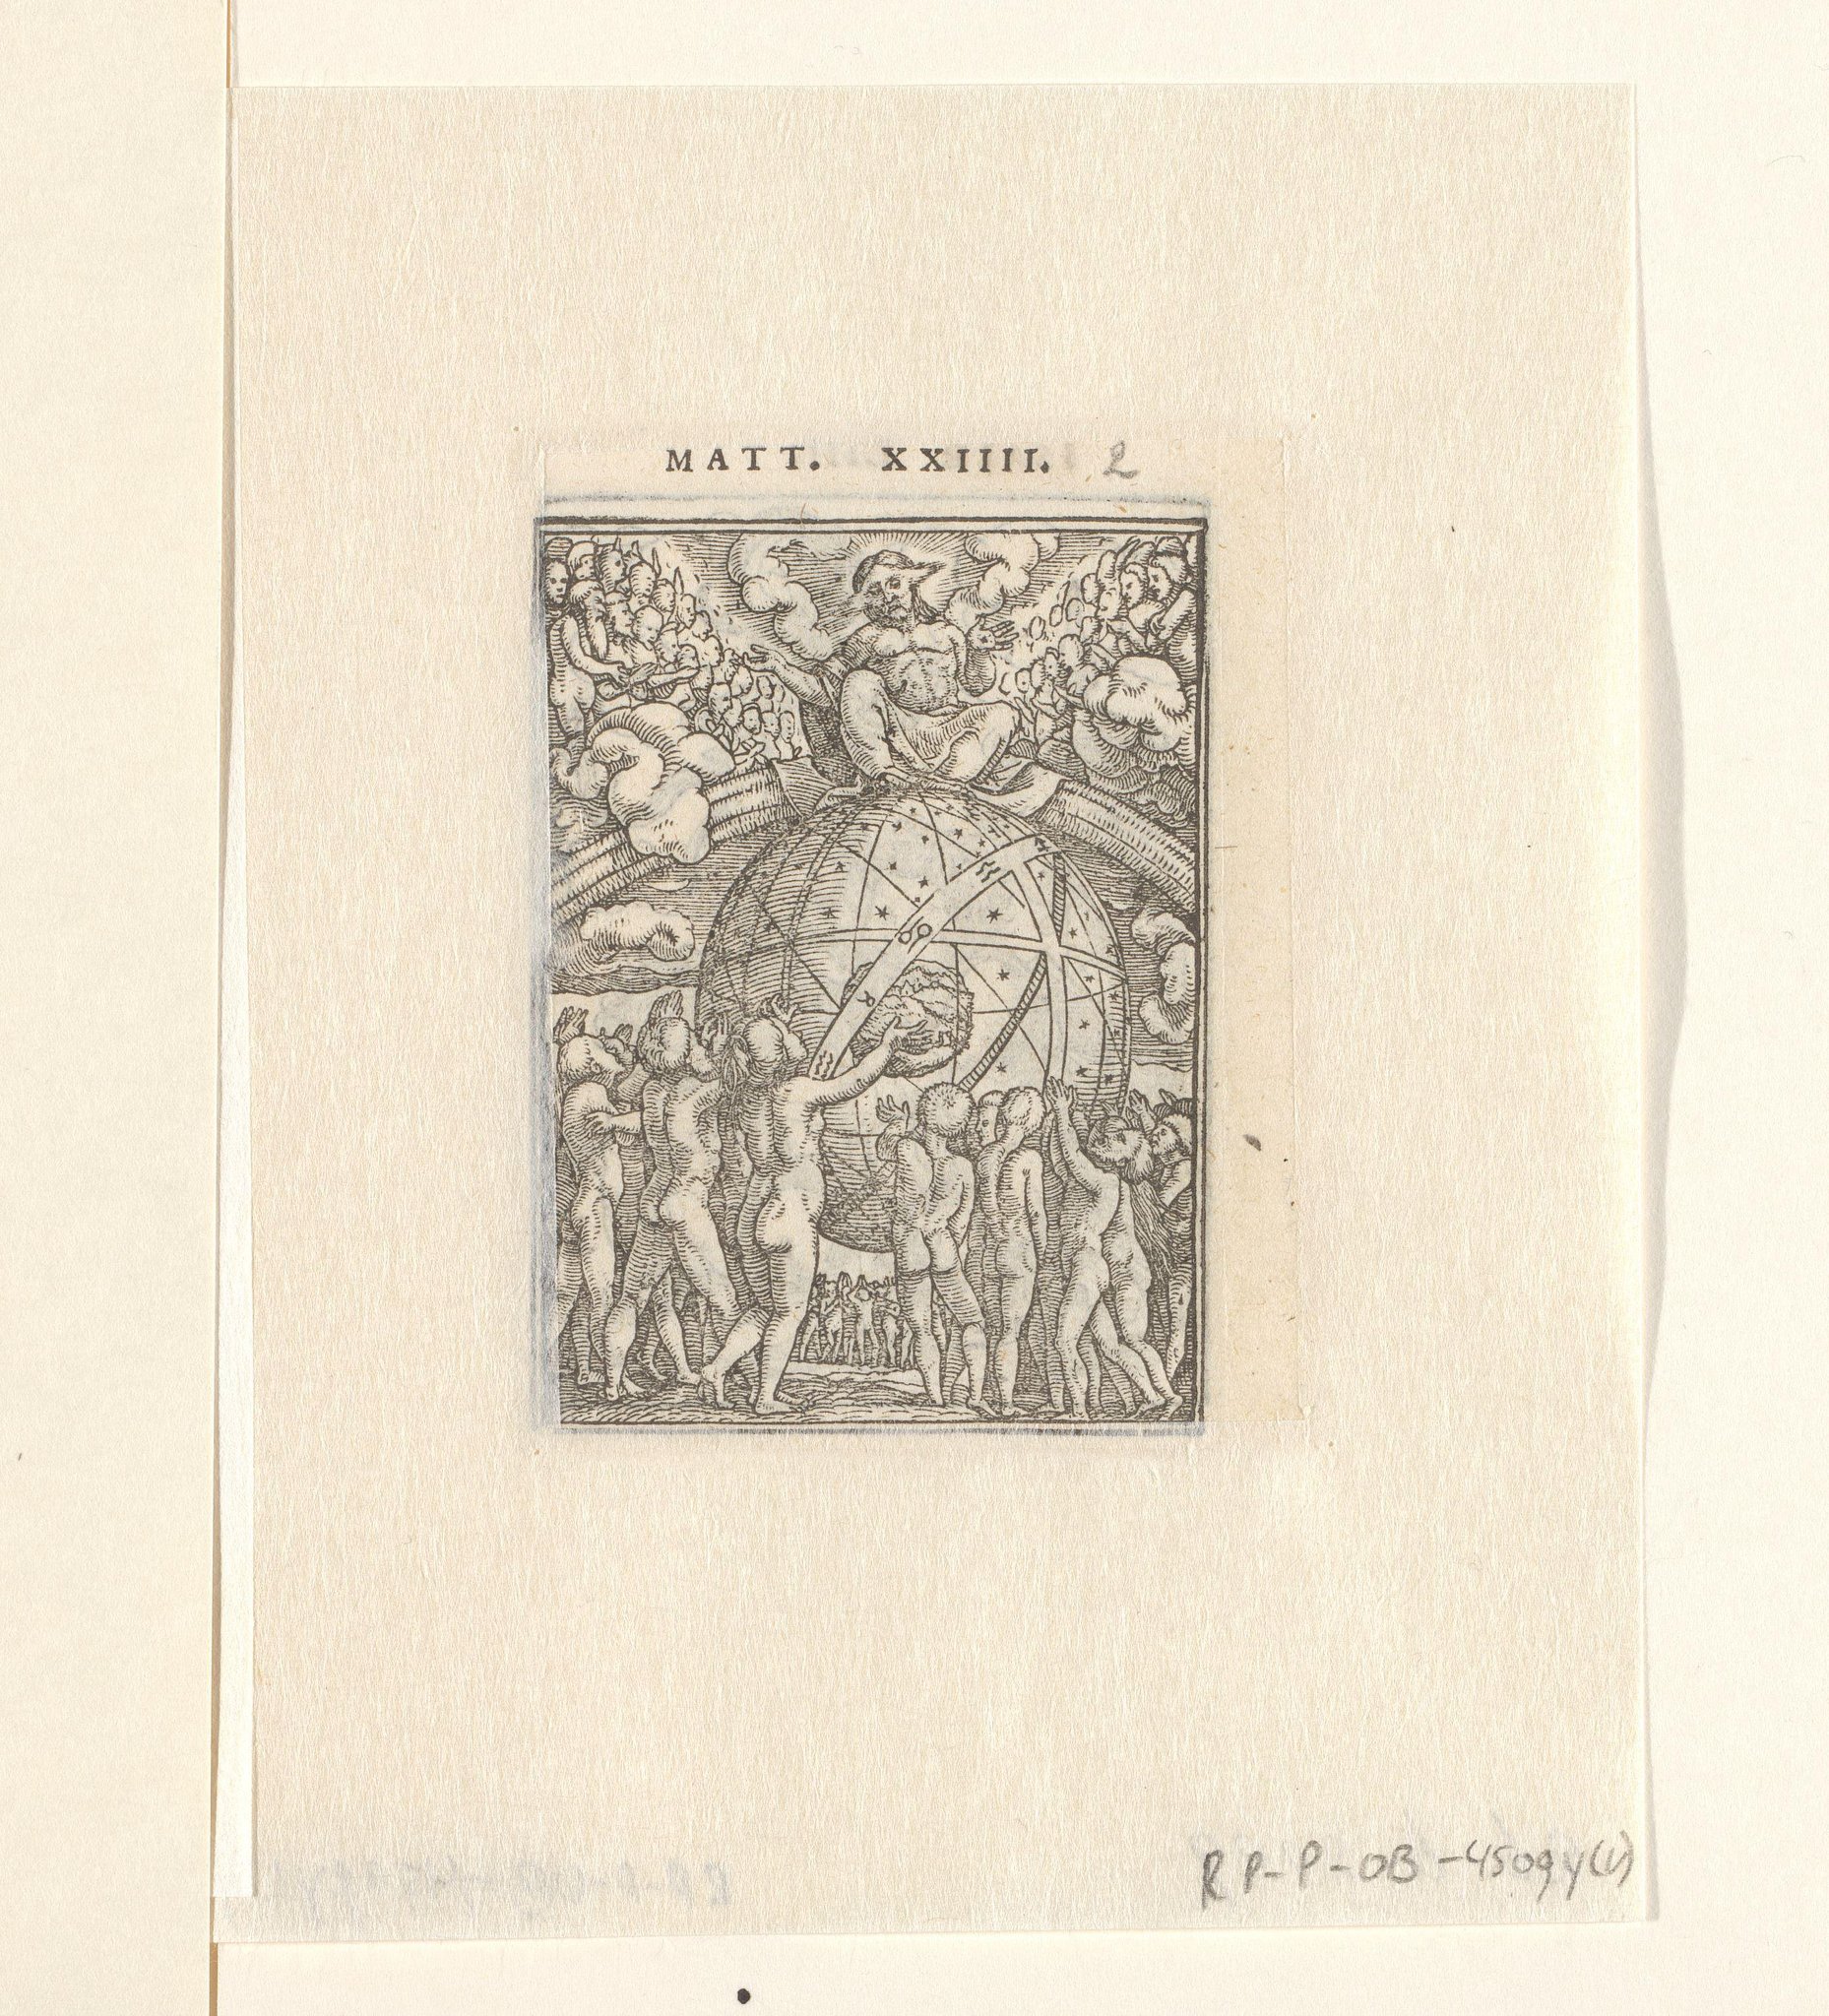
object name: book illustration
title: Dodendans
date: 1524-1526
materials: paper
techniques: woodcut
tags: last judgement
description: De houtblokken werden voor 1526 vervaardigd door Hans Lützelburg en pas in 1538 voor het eerst gebruikt als boekillustraties in: Les simulachres & historiees faces de la mort avtant elegamment pourtraictes que artificiellement imaginées... a Lyon, Soubsz l'escu de Coloigne, MDXXXVIII, (M. en G. Trechsel, voor F. Frellon in Lyon), 1538. Later verschenen nog andere uitgaven.